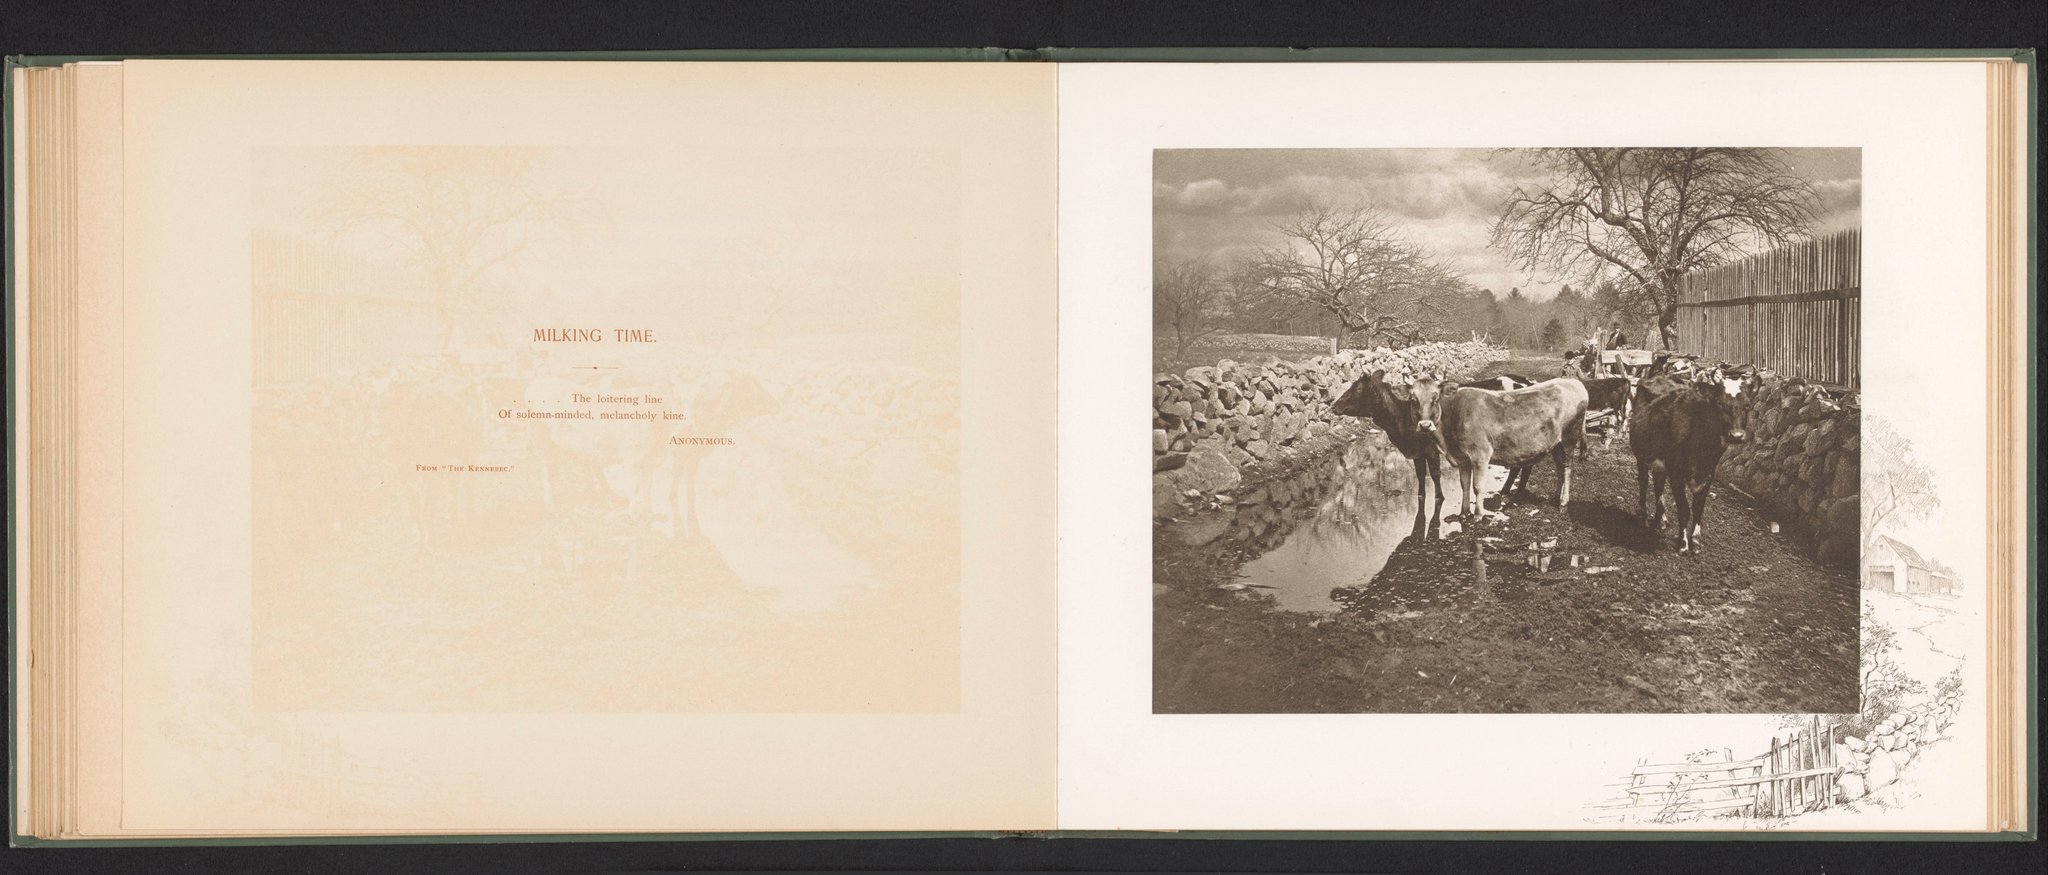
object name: page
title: Koeien bij een plas water in New England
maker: Anonymous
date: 1880-1890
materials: paper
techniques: photoaquatint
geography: new england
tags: cow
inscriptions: inscription: ‘Milking time. (...)’